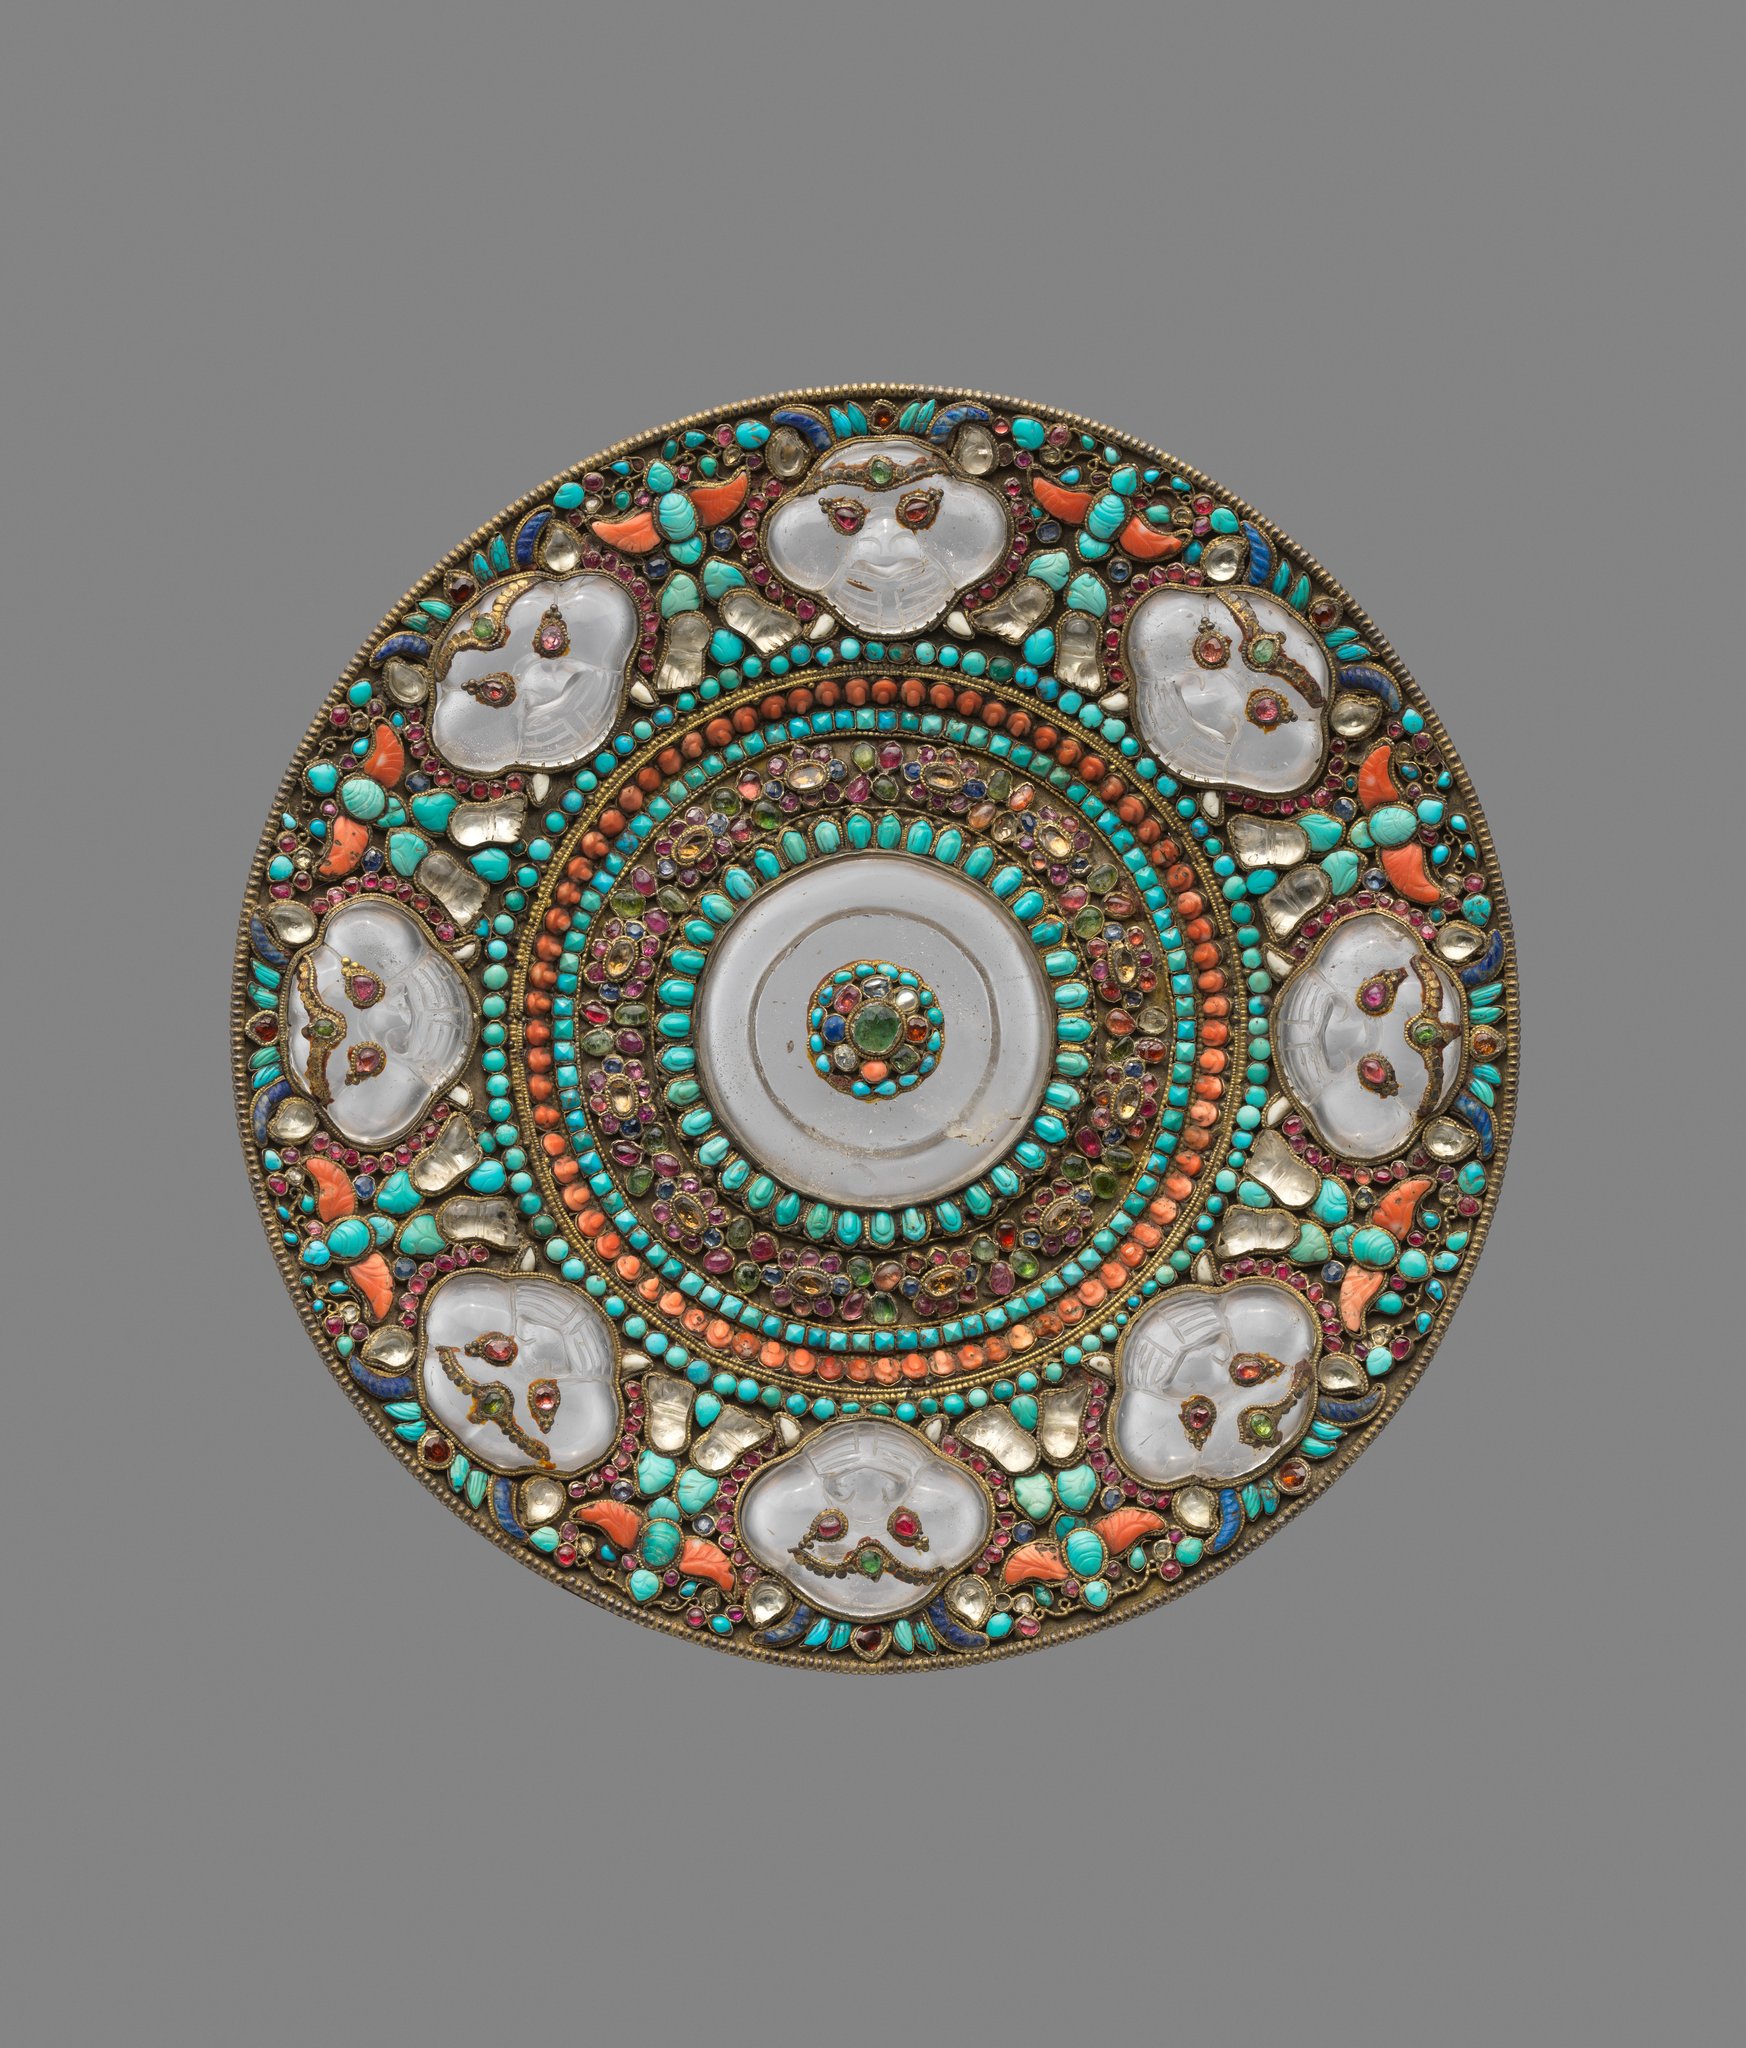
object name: dish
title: Dish for Ritual Offerings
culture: nepali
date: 1601-1900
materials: amber, coral, gemstone, garnet, silver gilt, lapis lazuli, quartz, shell, stone